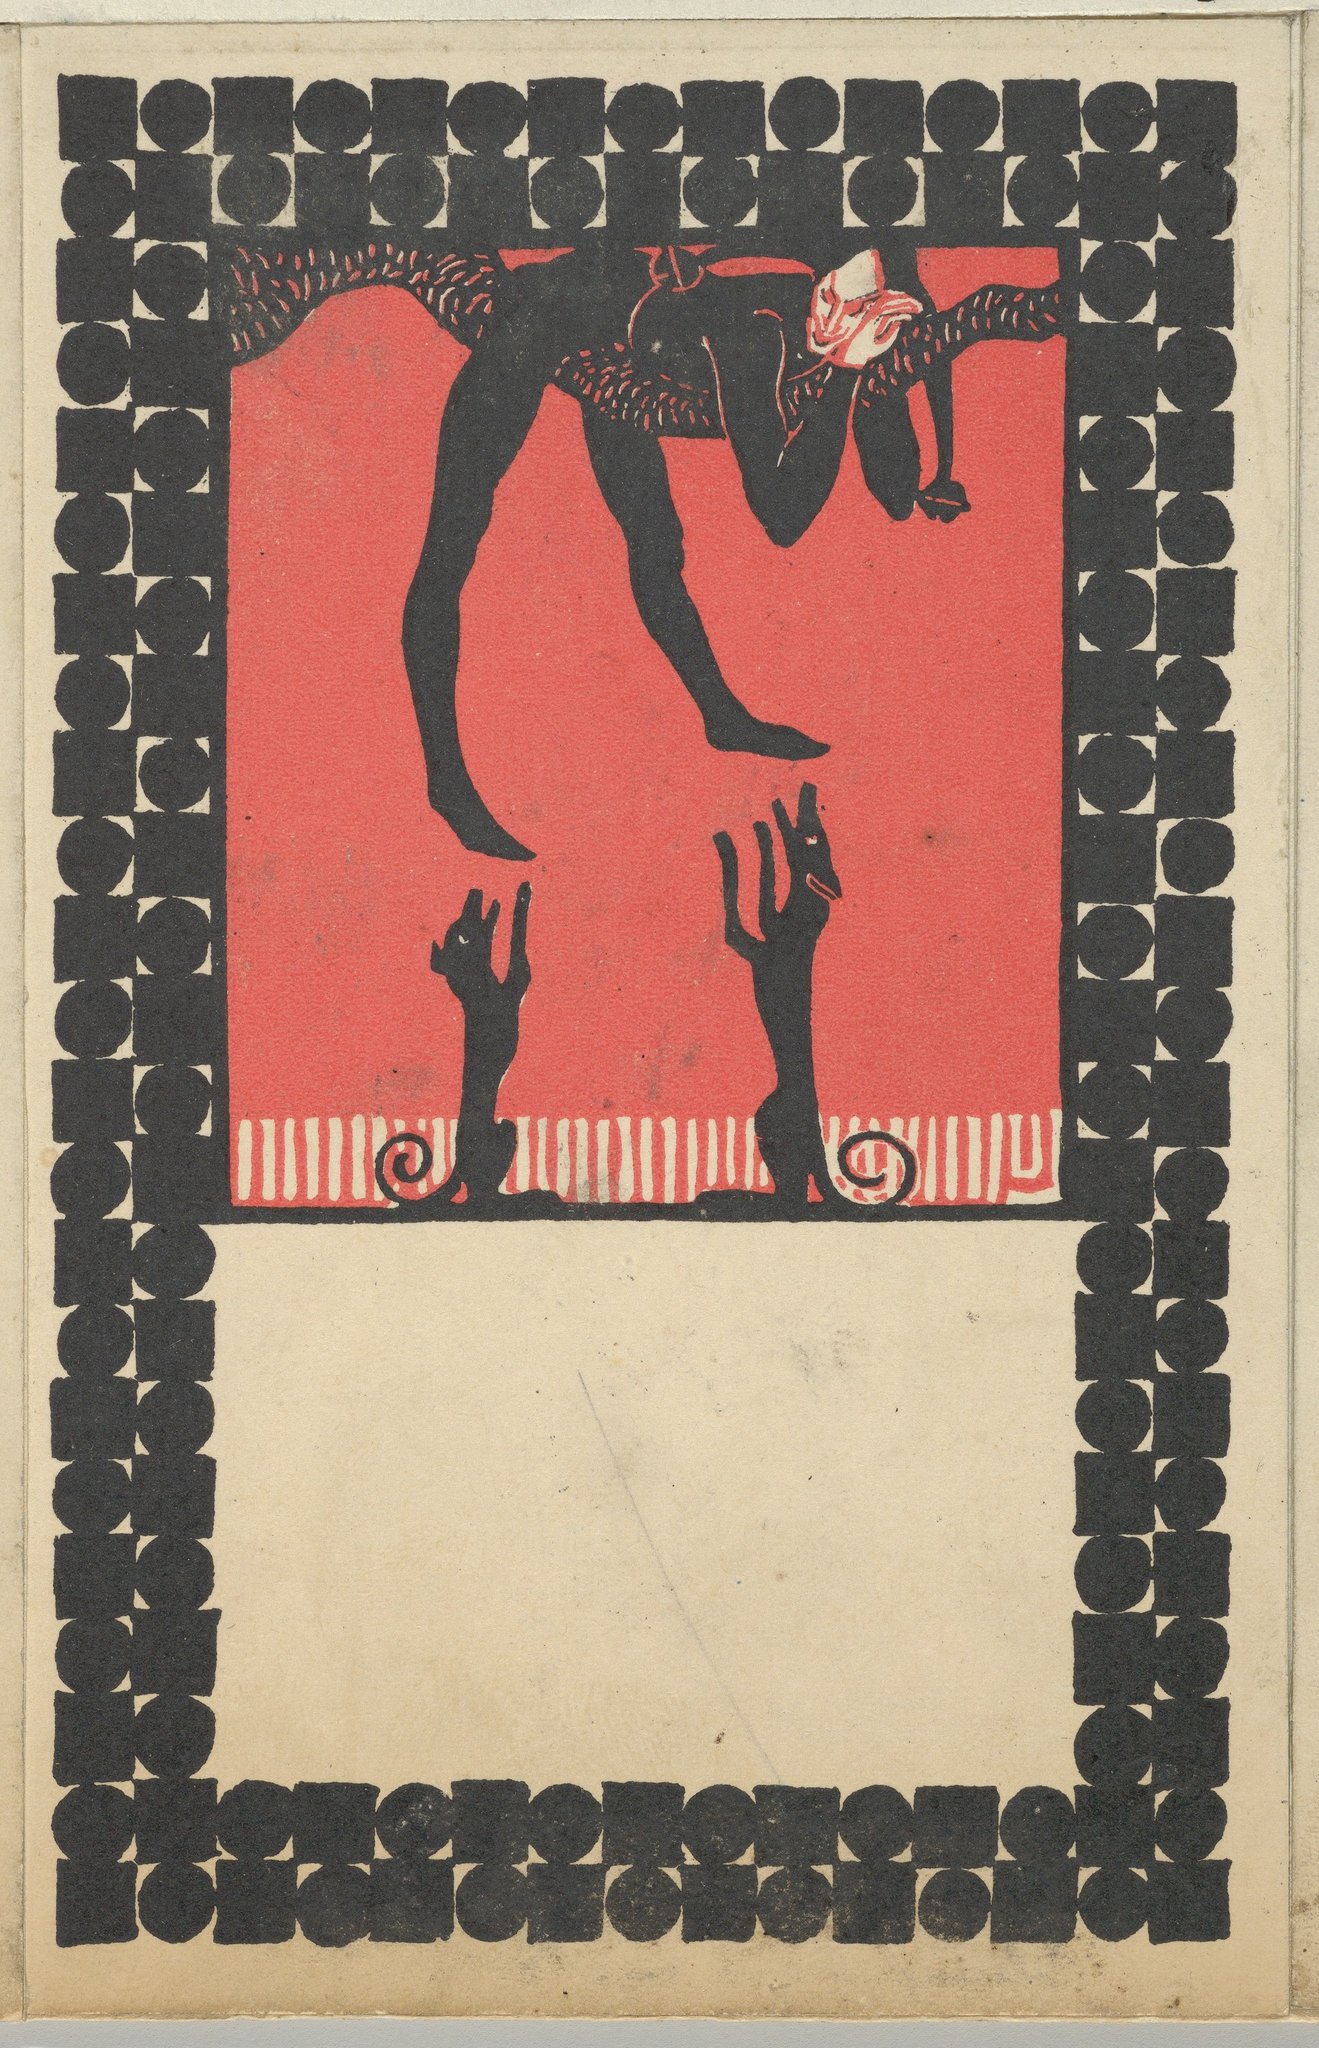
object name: print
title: Till Eulenspiegel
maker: urban janke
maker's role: artist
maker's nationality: austrian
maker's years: 1887-1914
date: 1907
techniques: lithograph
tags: human figures,dogs